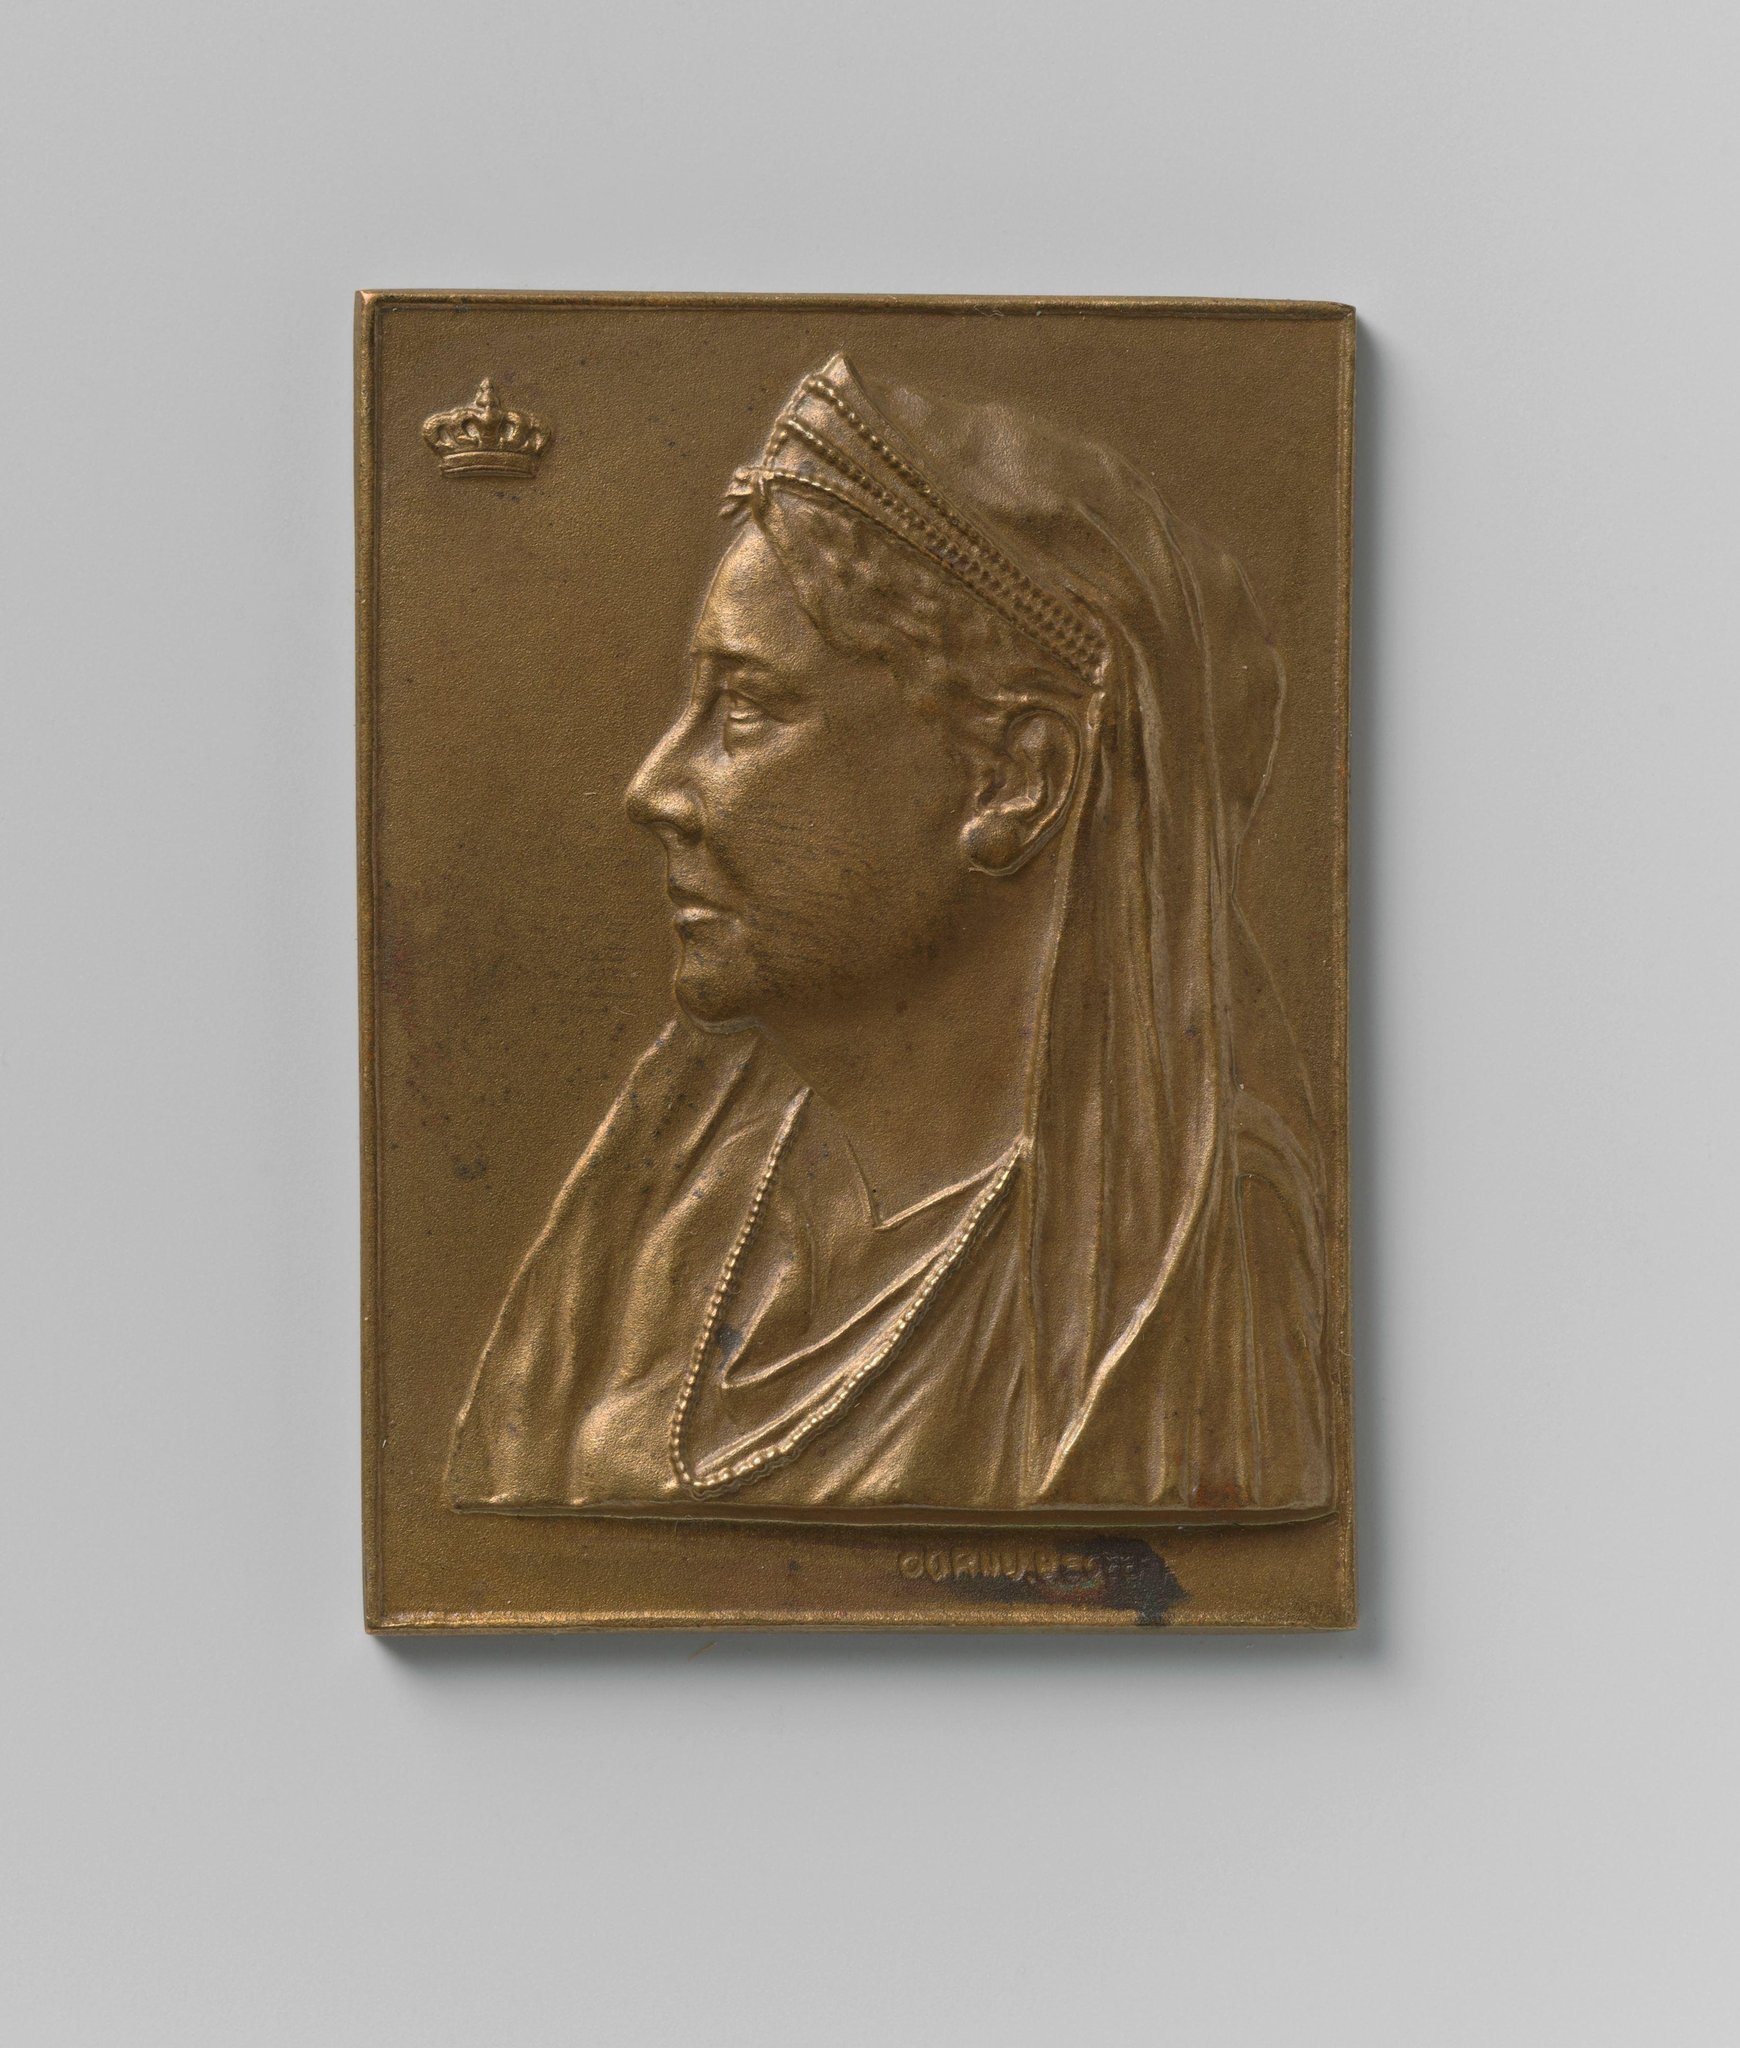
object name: history medal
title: Zesenvijftigste verjaardag van Koningin Wilhelmina 1936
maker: cornelis l.j. begeer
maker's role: juwelier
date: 1936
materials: bronze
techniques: striking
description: Kleine messing plakkette, op de voorzijde het gesluierde borstbeeld van Wilhelmina naar links met linksboven een kroontje, de keerzijde blanco.